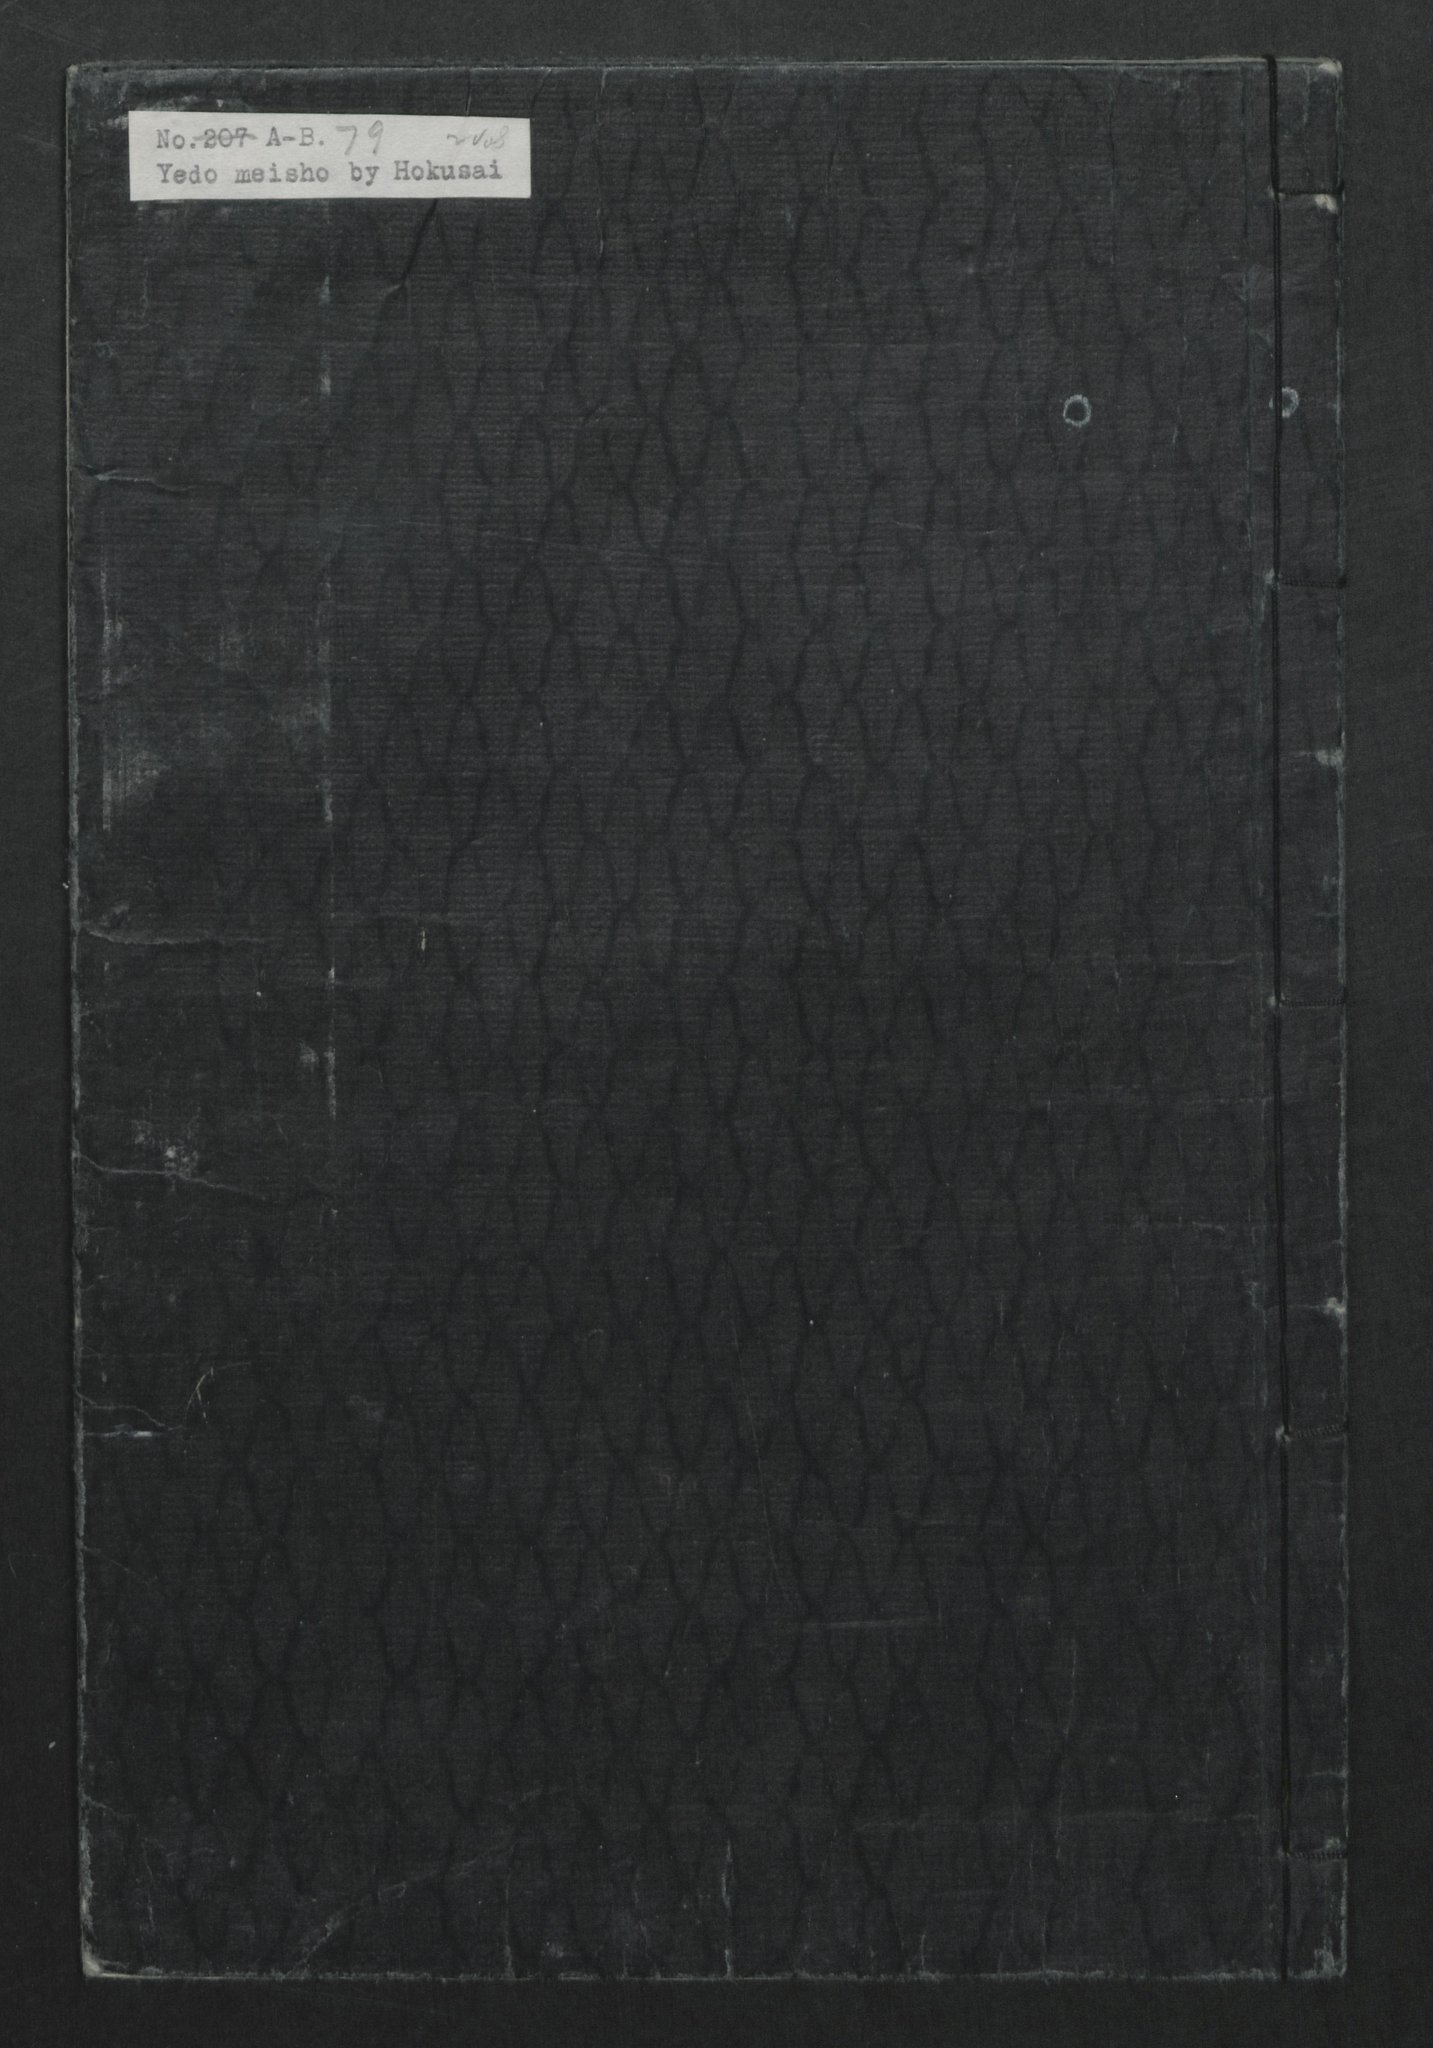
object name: illustrated book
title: Famous Sites of Edo (Tōto meisho ichiran) 東都名所一覧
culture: japanese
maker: katsushika hokusai 葛飾北斎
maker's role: artist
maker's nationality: japanese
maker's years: 1760-1849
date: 1800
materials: ink, paper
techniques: polychrome, woodblock print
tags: men,women,tea houses